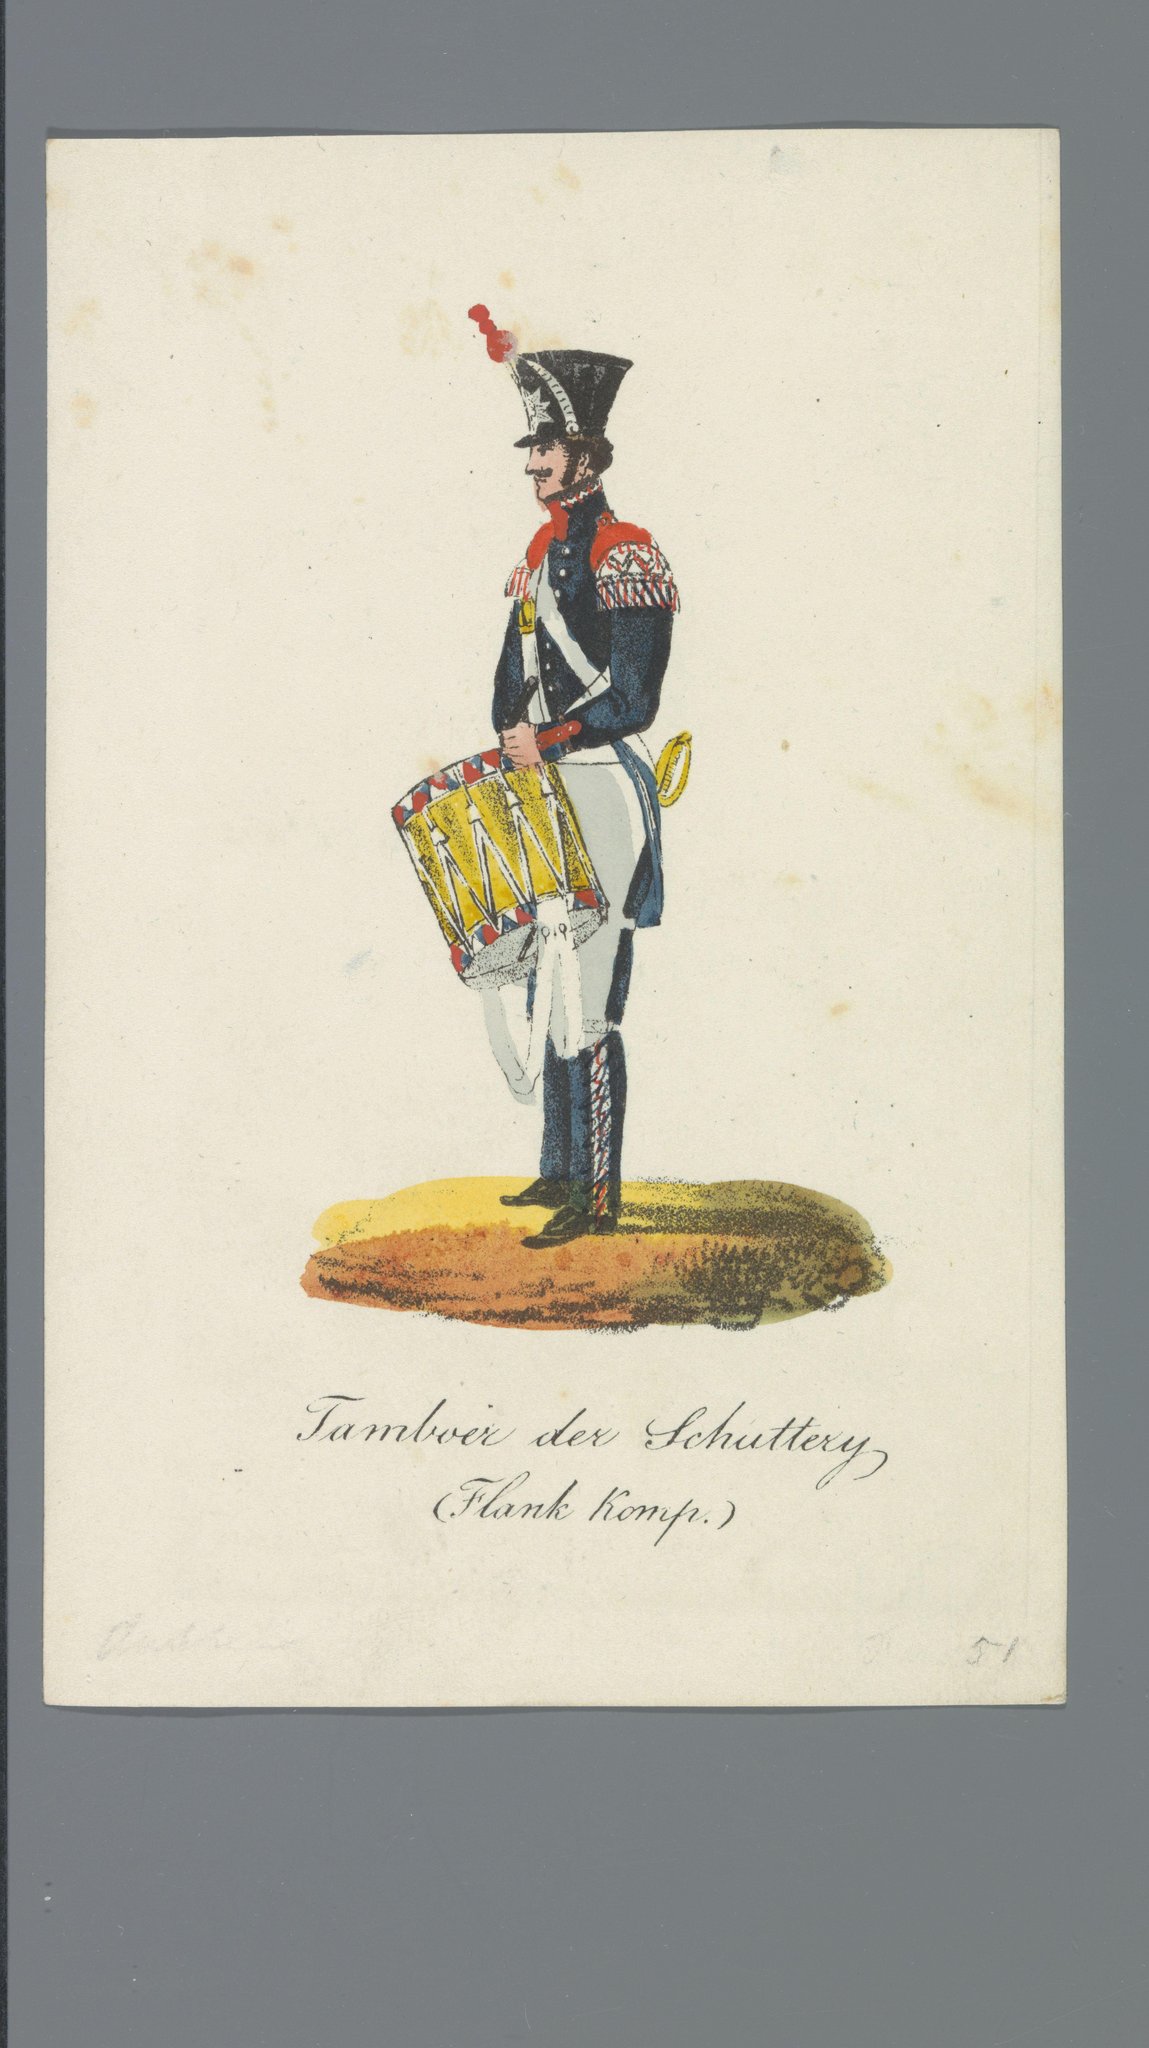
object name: costume print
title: Tamboer der Schutterij (Flank Komp.)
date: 1835-1850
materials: paper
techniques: hand coloring, lithograph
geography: netherlands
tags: (military) uniforms, clothes, costume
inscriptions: collector's mark: Lugt 2227, collector's mark: Lugt 2228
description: Staande tamboer van een compagnie flankeurs van de Schutterij. Onderdeel van een serie van 157 losse bladen met Nederlandse militaire uniformen in de jaren 1830-1832.